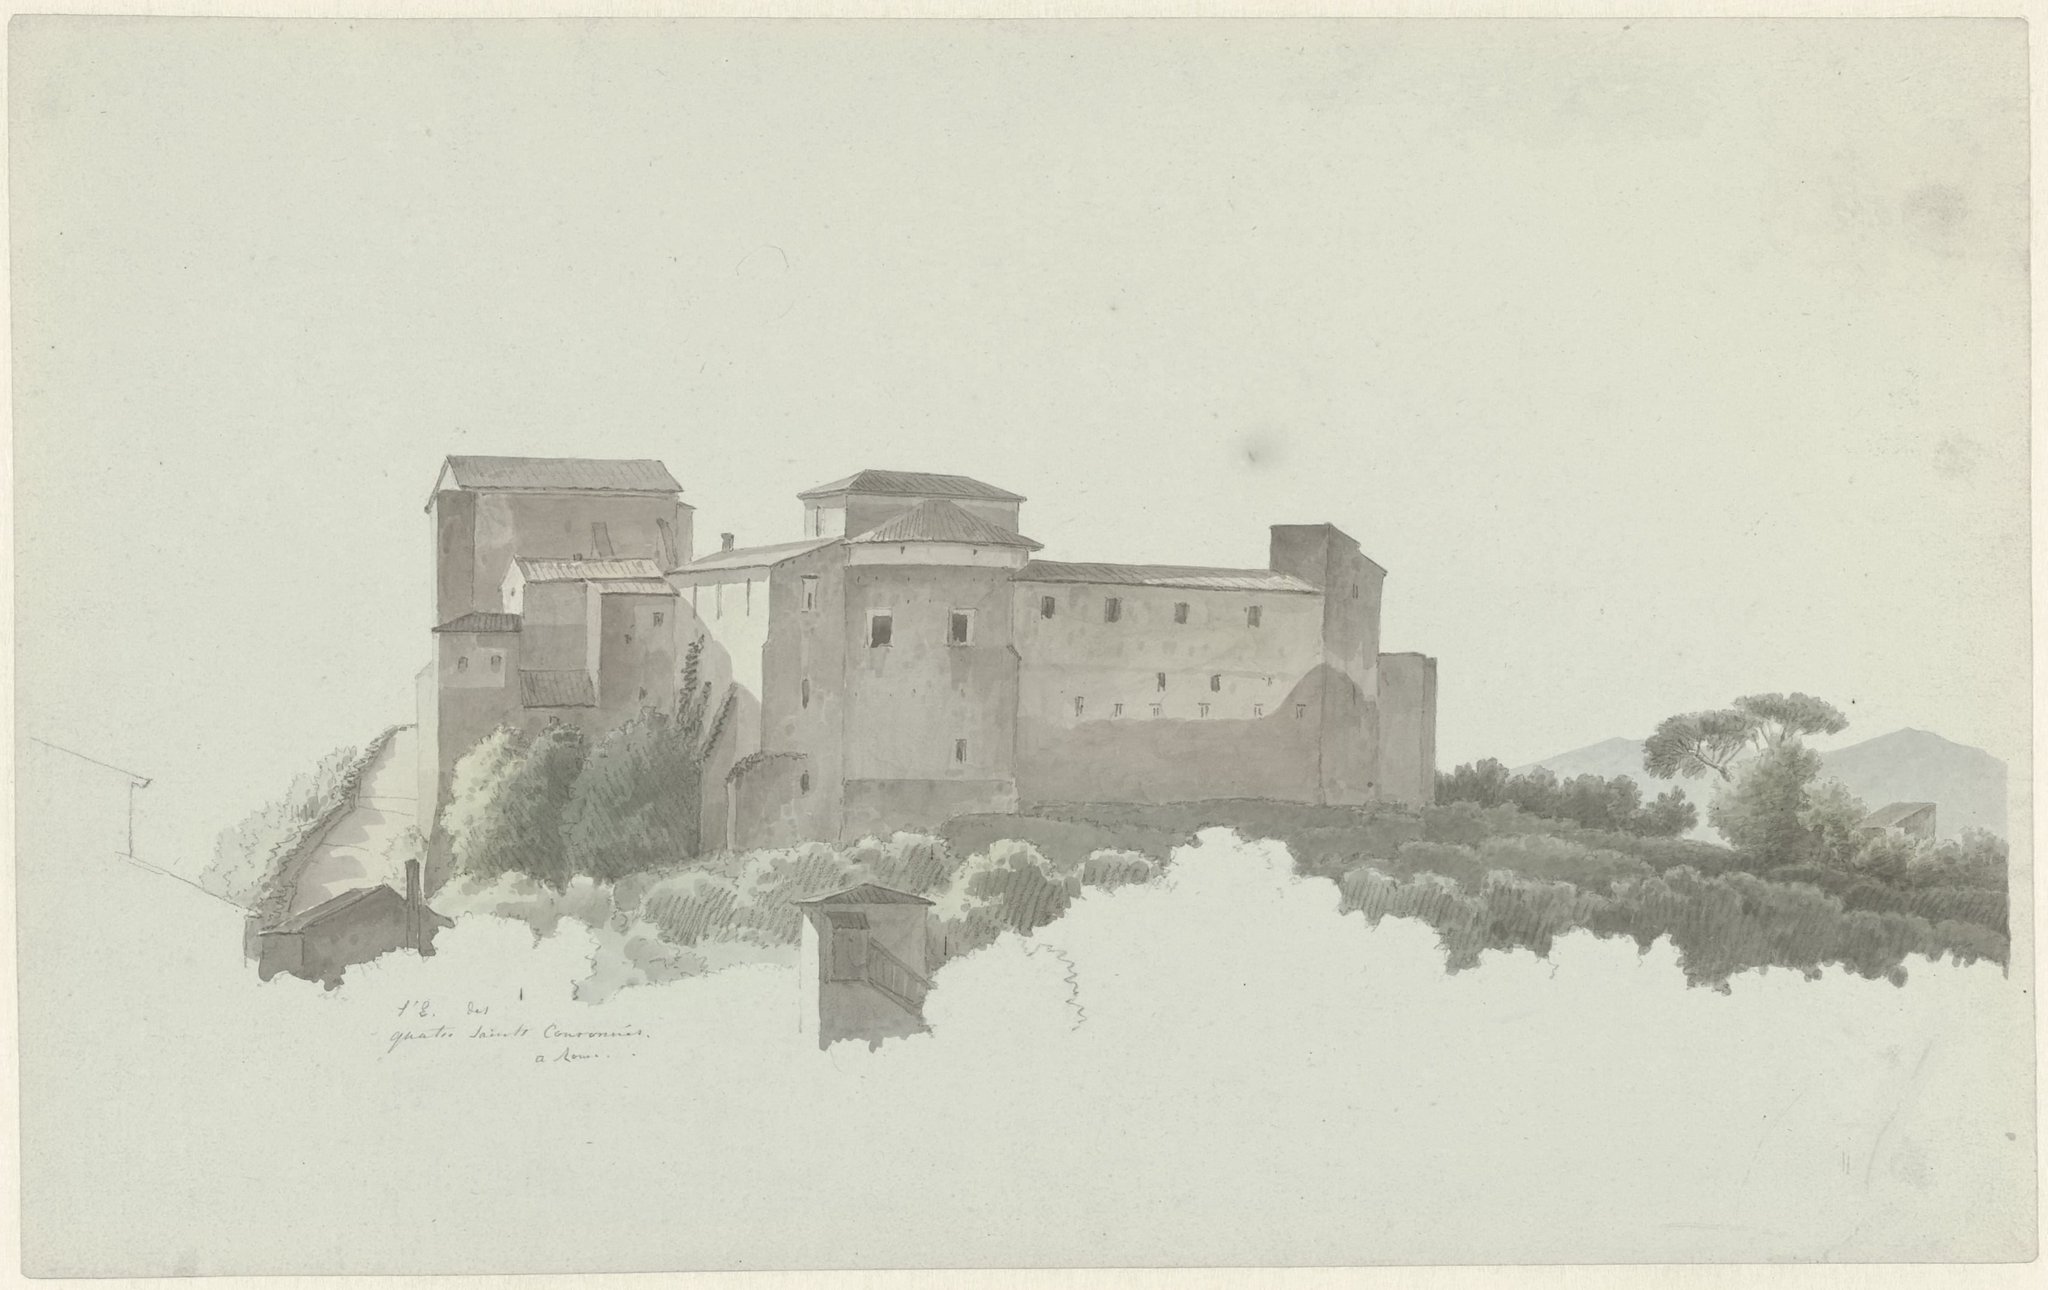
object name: drawing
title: The Basilica and Monastery of the Quattro Santi Coronati in Rome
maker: josephus augustus knip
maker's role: draughtsman, painter, print maker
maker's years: 1777-1847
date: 1809-1812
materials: graphite, paper, watercolor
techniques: brush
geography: italy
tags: church (exterior), rome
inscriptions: inscription: ‘l'E. des / quatre Saints Couronnés. / a Rome’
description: Even now this complex, located halfway between the Colosseum and the basilica of San Giovanni in Laterano, still looks like a virtually impenetrable medieval stronghold. According to legend, the ‘Four crowned martyrs’ to whom the church is consecrated were sculptors who refused to make pagan idols. They were tortured by being forced to wear iron crowns with the sharp points pressing into their heads.